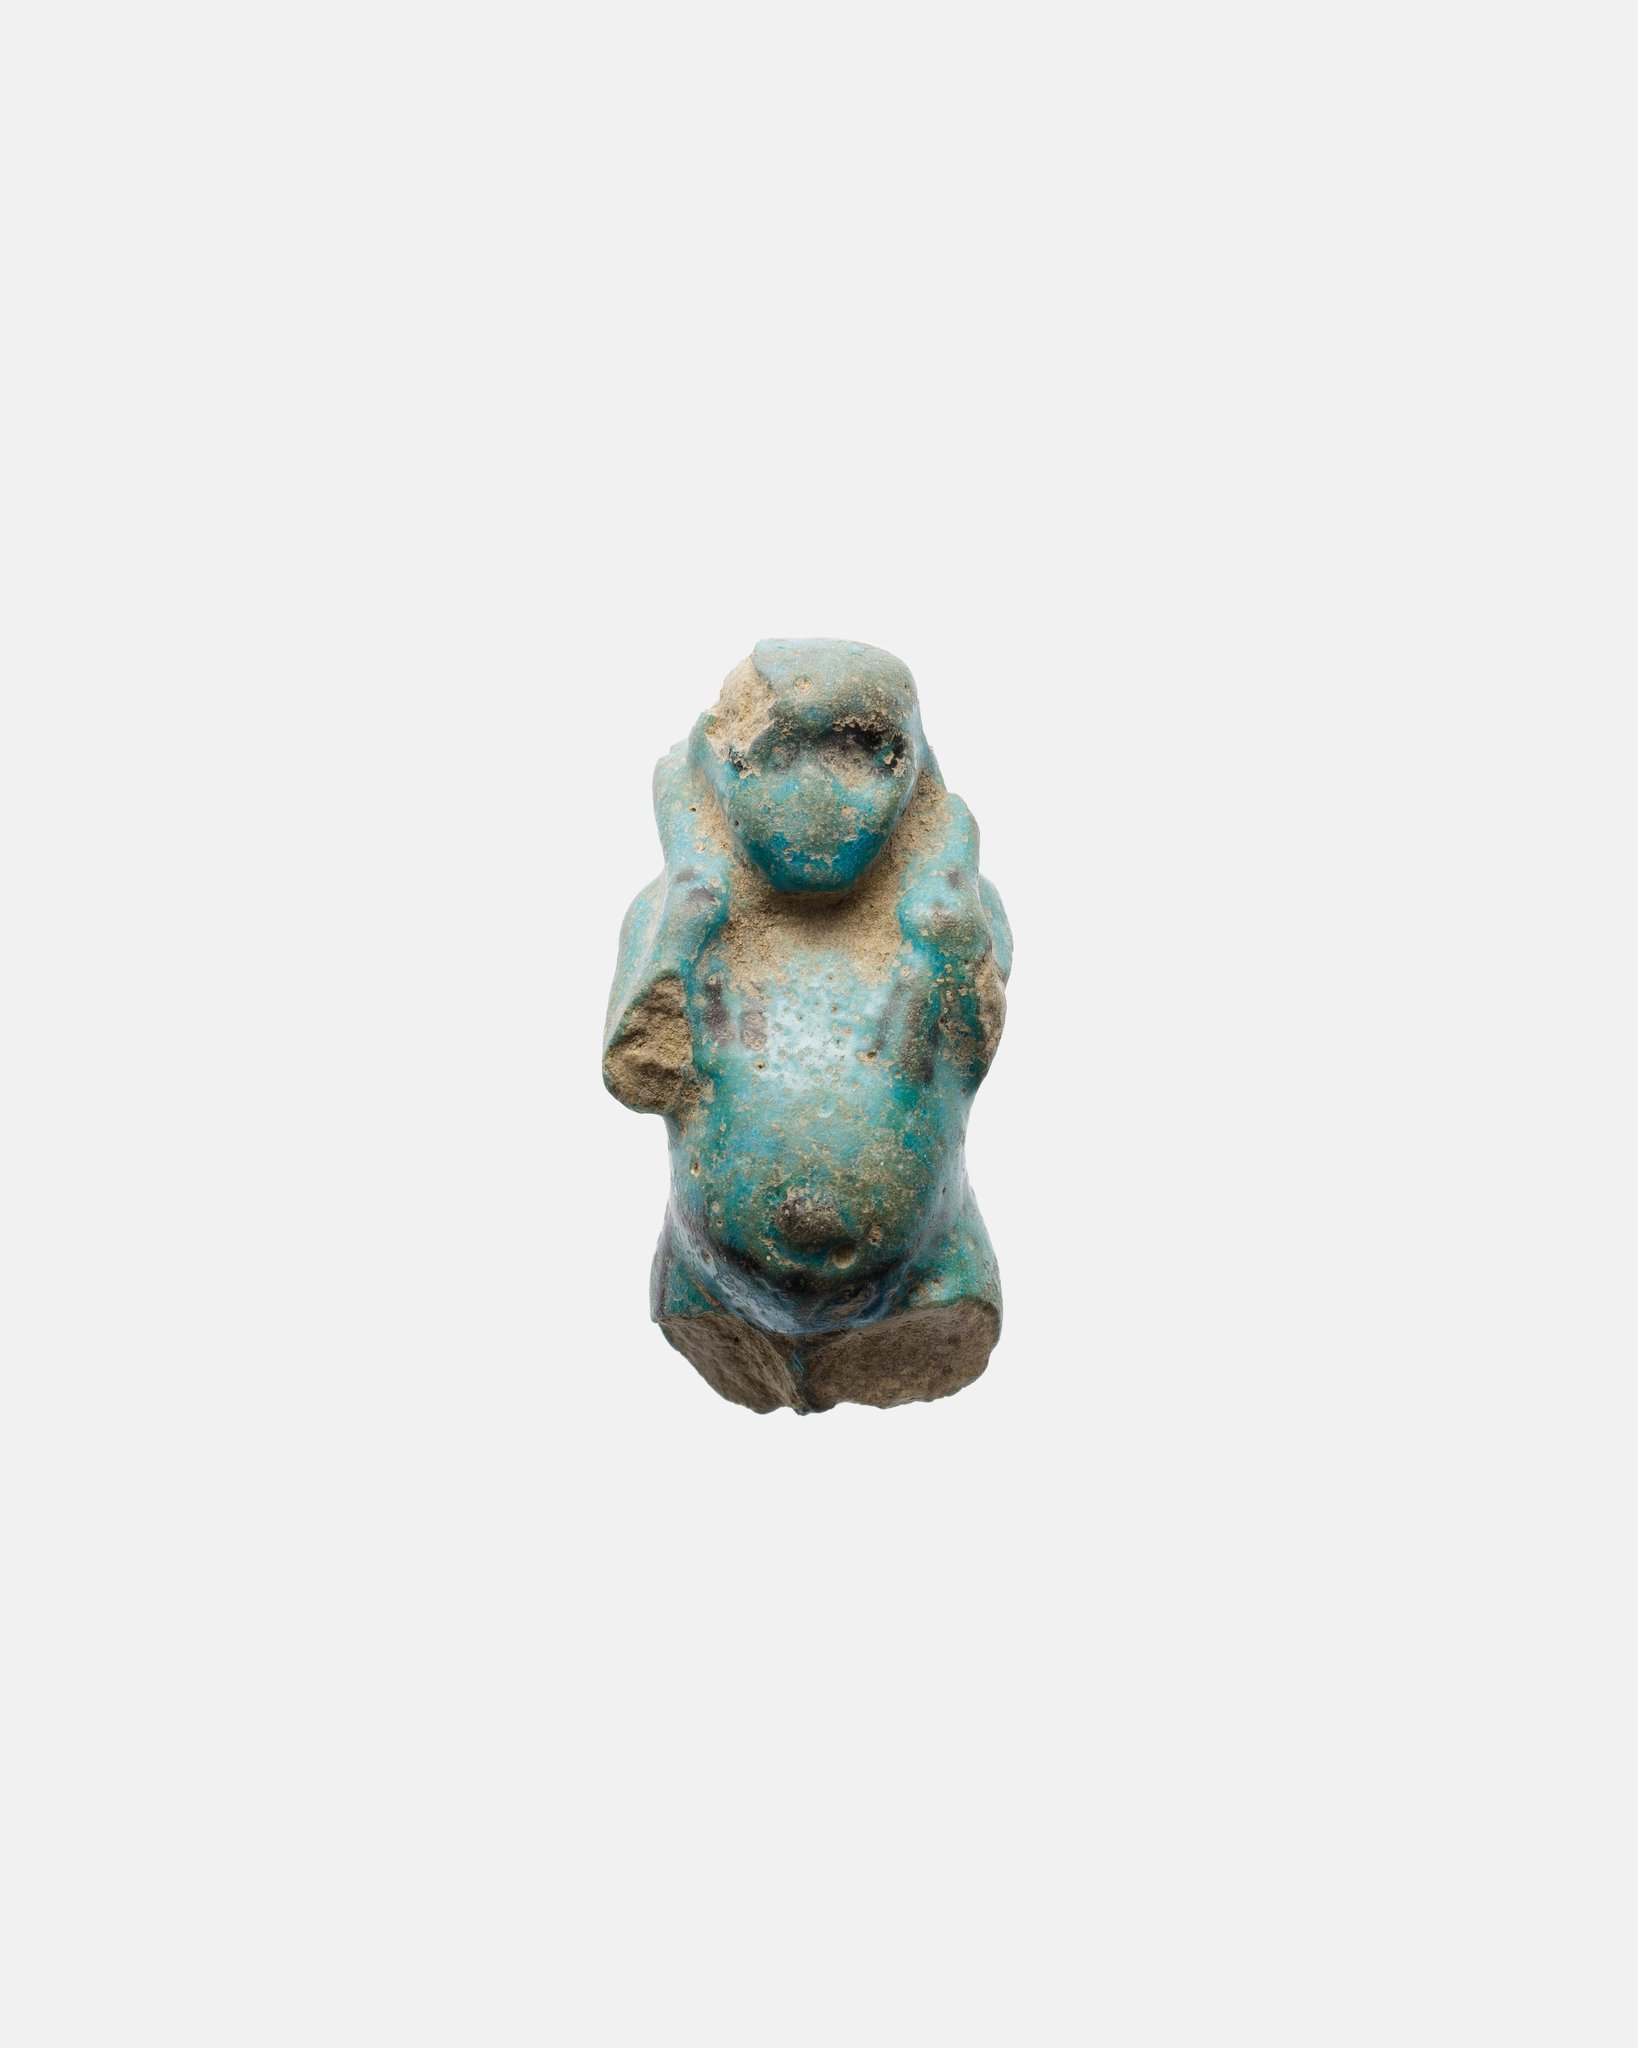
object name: figurine fragment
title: Part of a figurine of a female figure supporting a male on her back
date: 1981-1802 BCE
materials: faience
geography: egypt